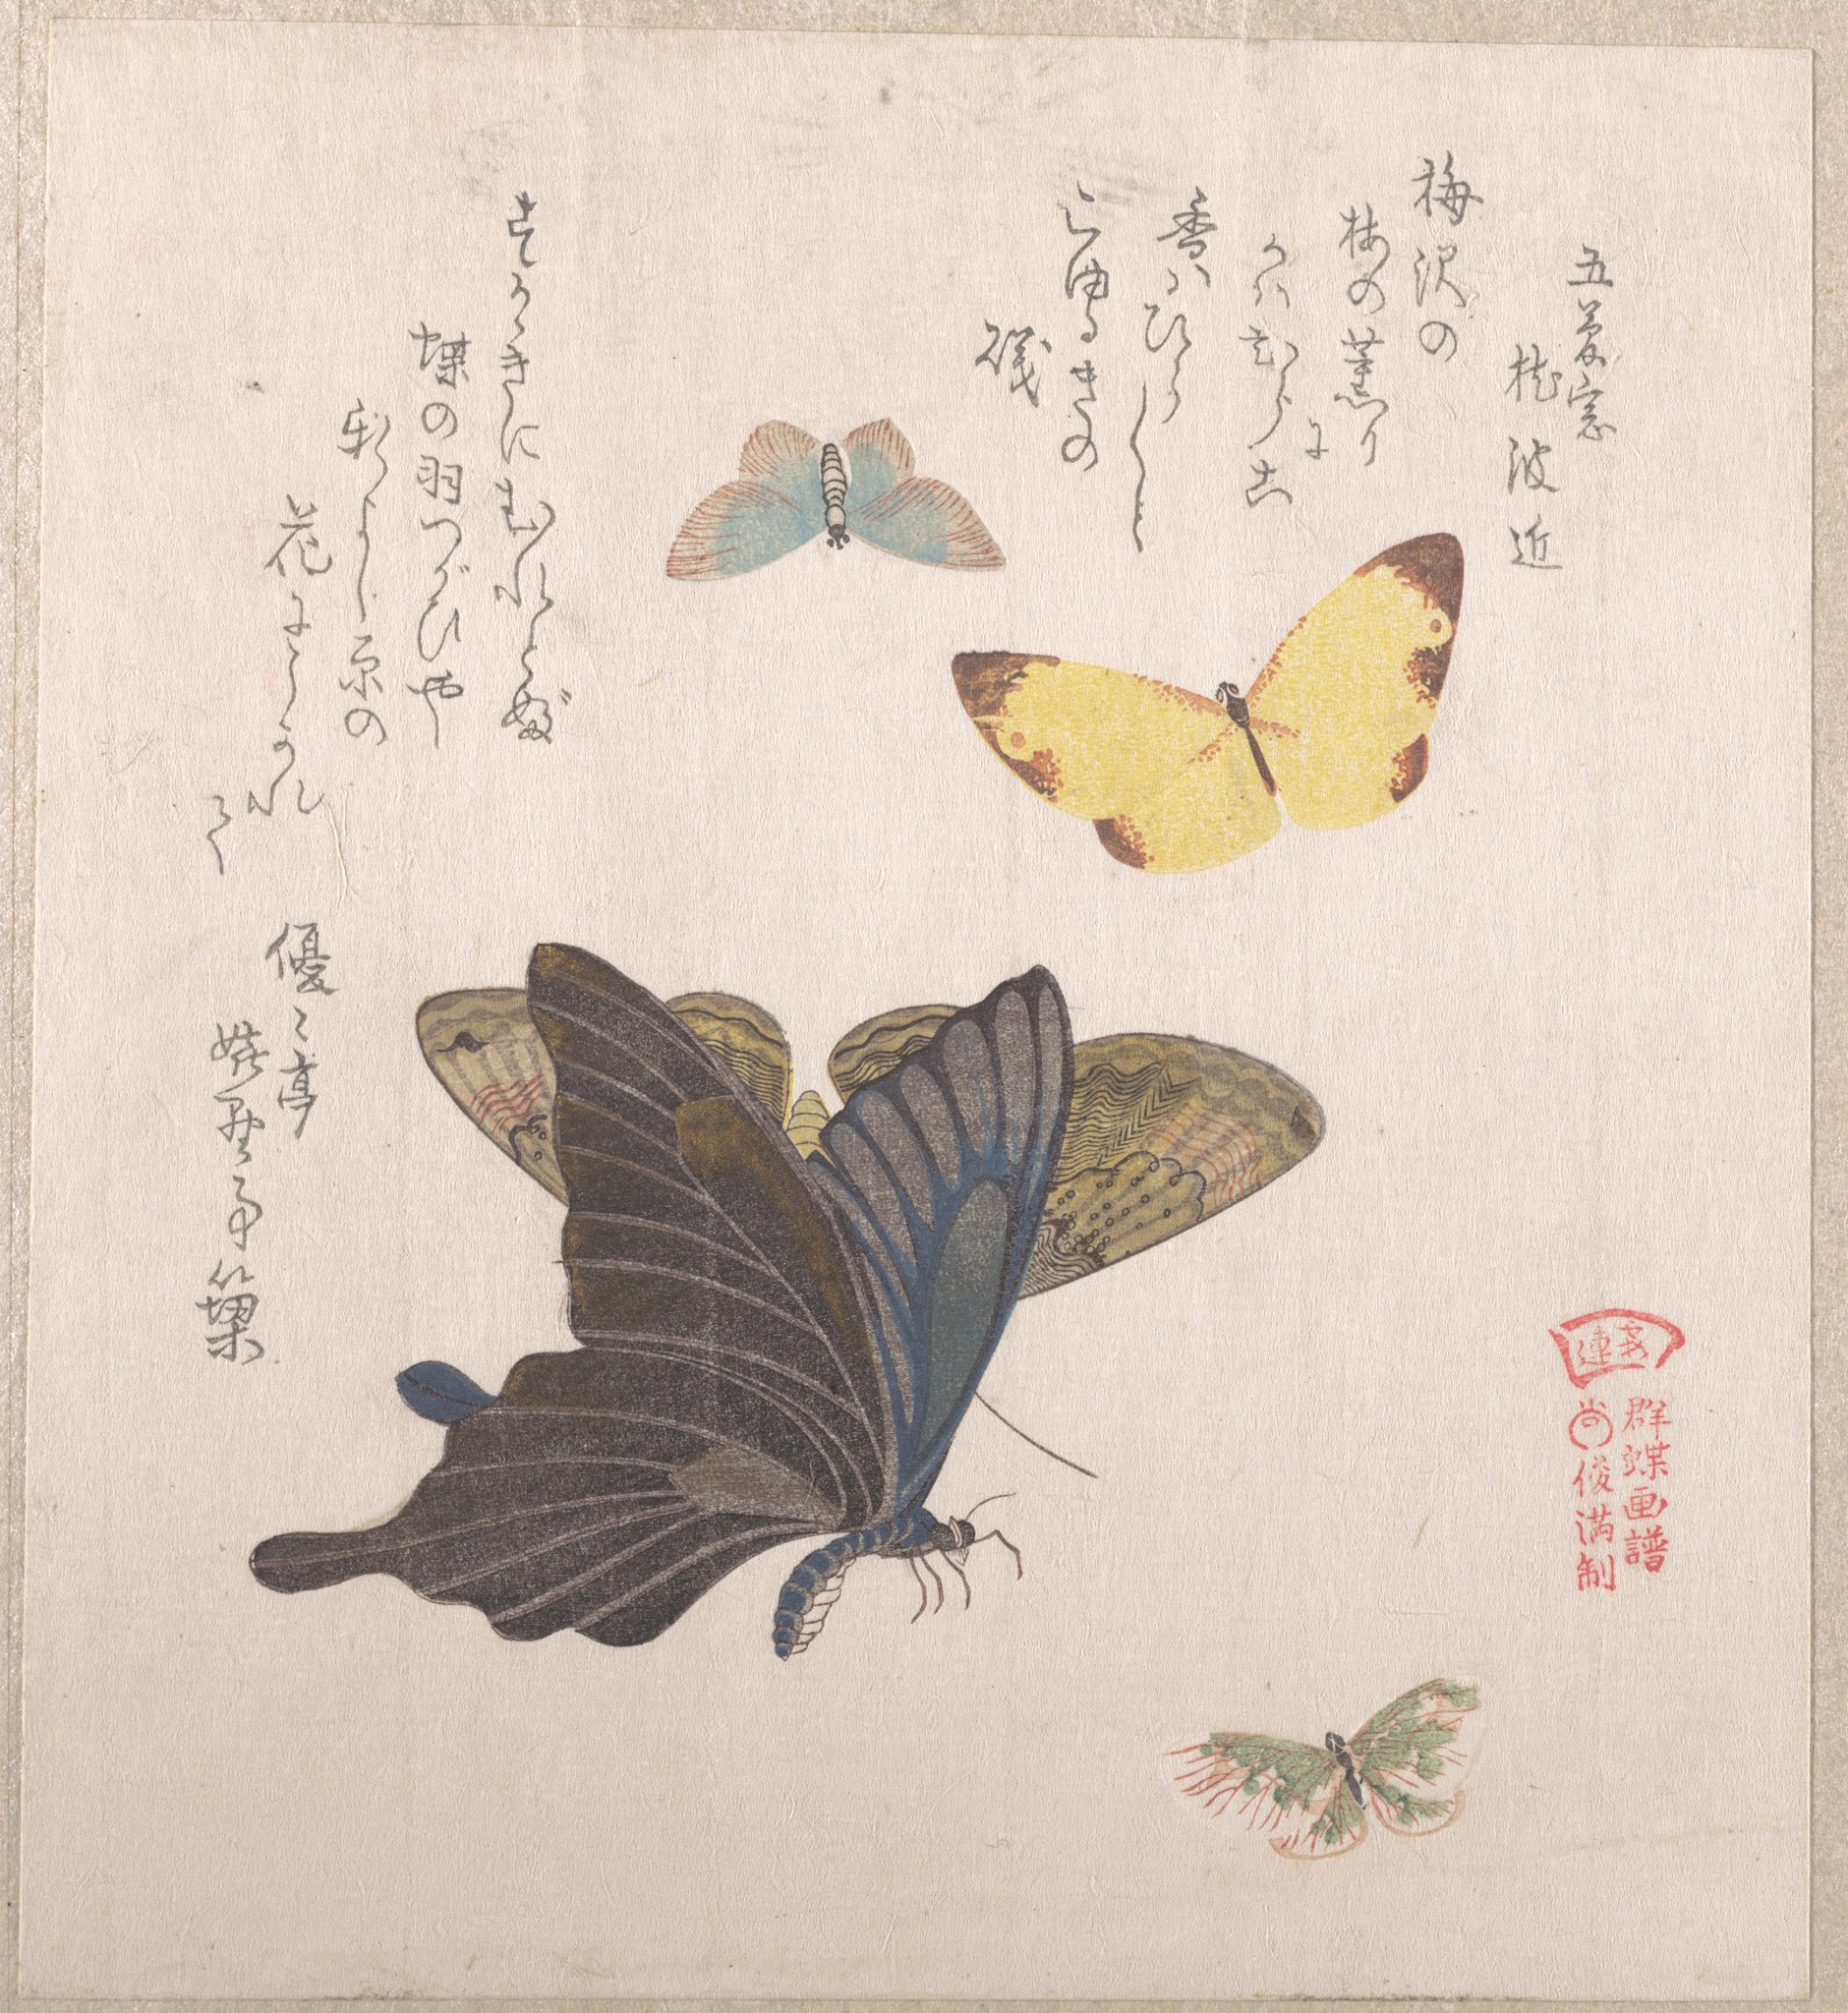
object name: print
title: Various Moths and Butterflies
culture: japanese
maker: kubo shunman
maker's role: artist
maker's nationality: japanese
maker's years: 1757-1820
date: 1801-1900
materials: ink, paper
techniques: surimono, woodblock print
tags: butterflies